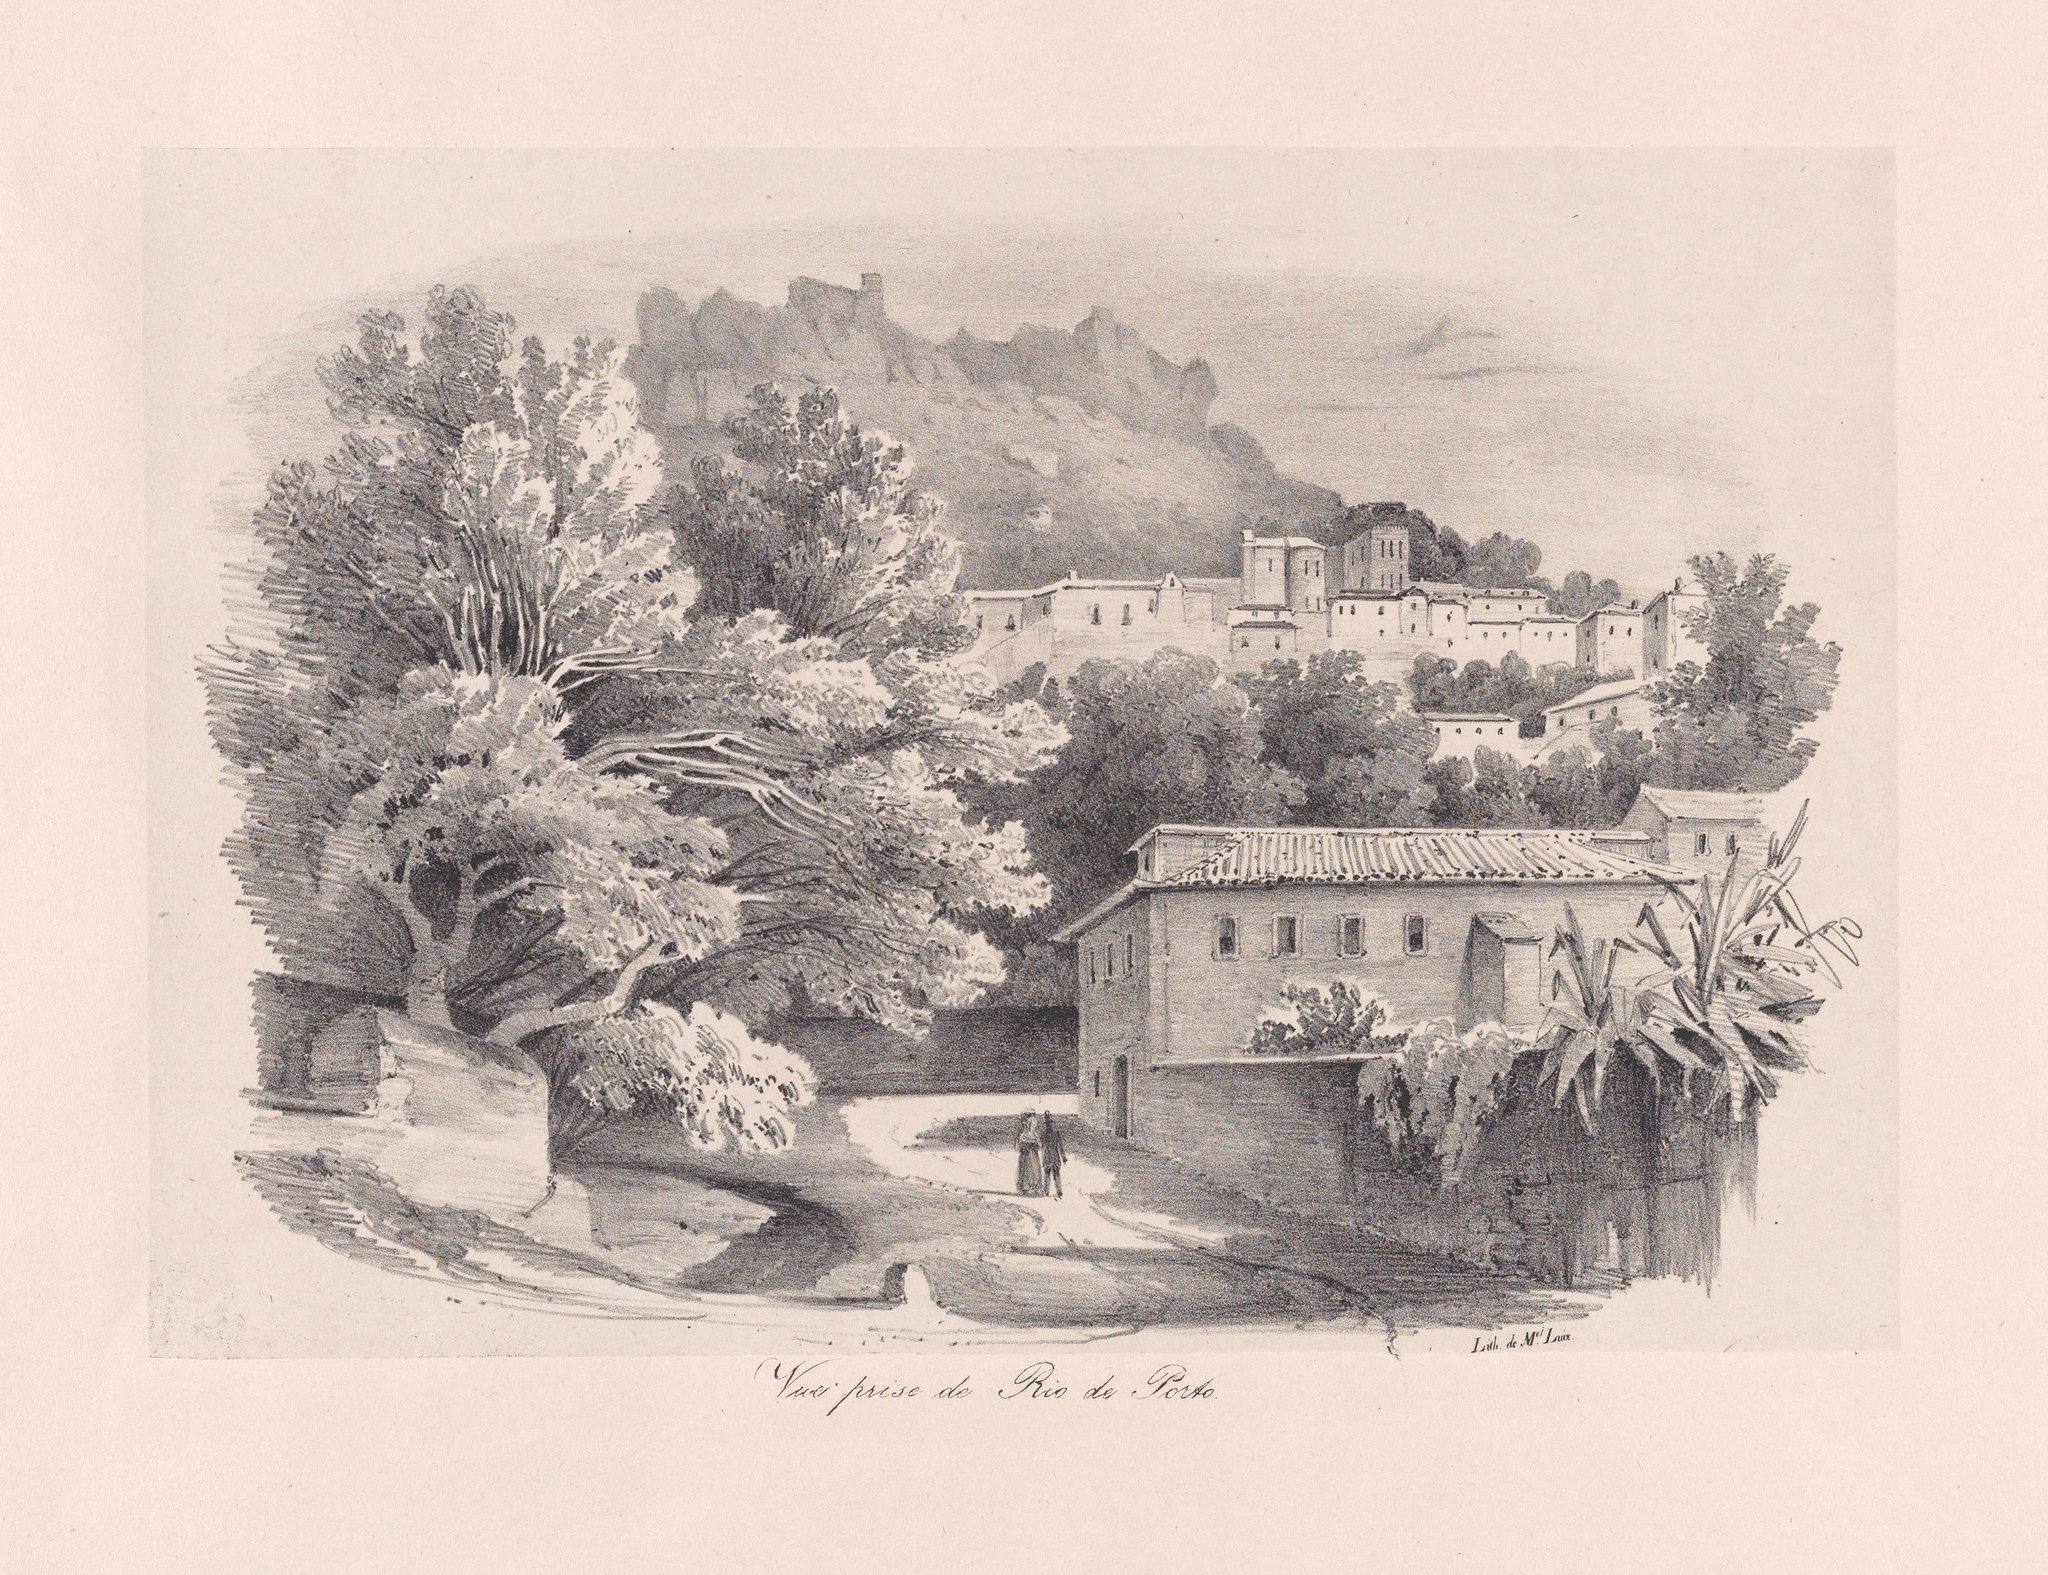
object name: print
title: View of Rio de Porto in Sintra with the Castle of the Moors in the background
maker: clementine de brelaz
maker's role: artist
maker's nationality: portuguese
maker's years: 1811-1892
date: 1840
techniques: printmaking, lithograph